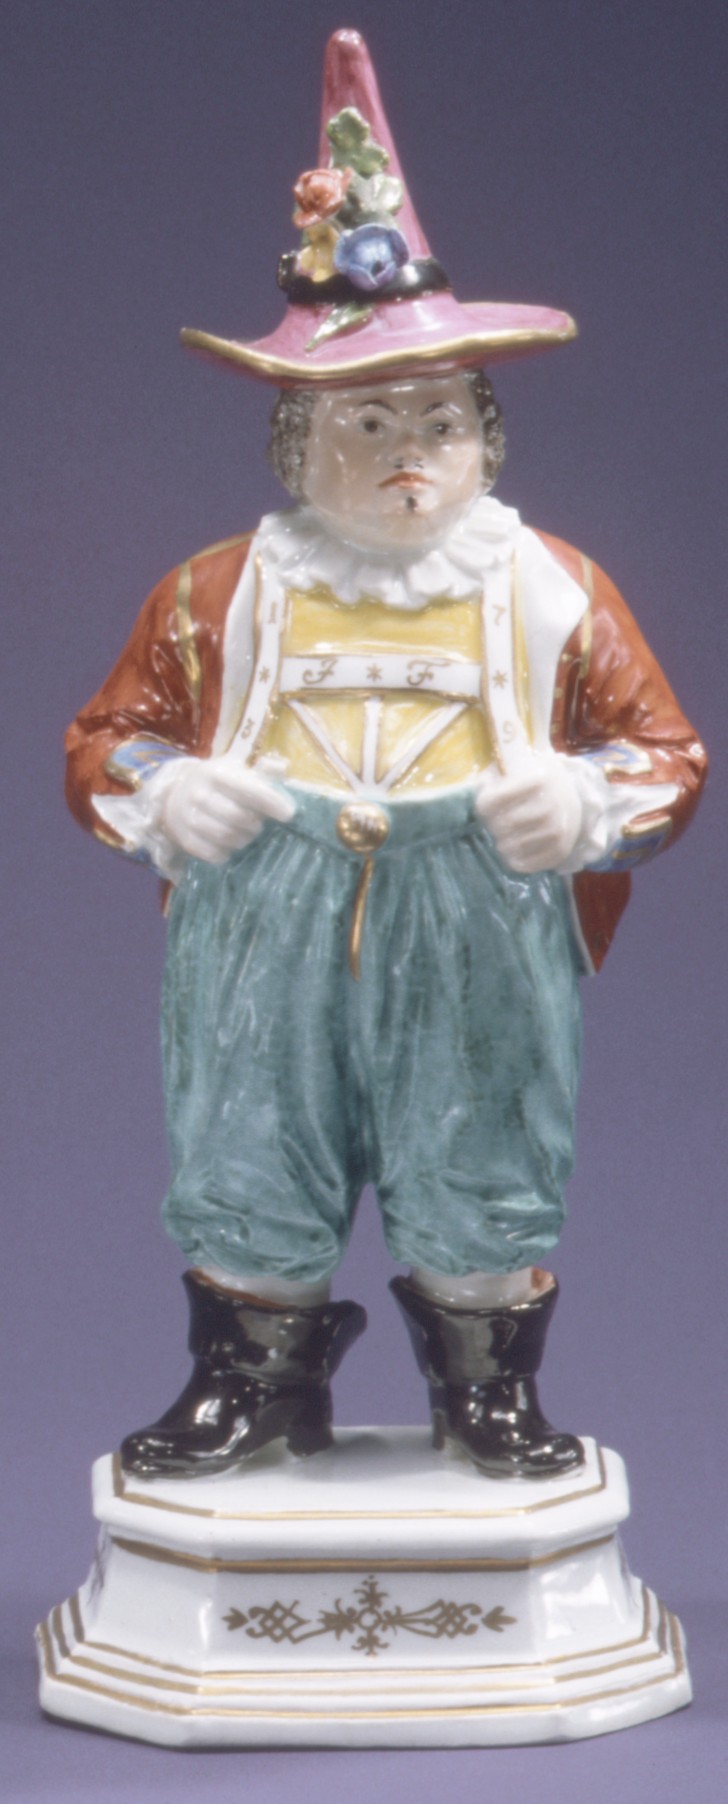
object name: figure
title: The Court Jester Joseph Fröhlich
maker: johann joachim kändler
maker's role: modeler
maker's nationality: german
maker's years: 1706-1775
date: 1739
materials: hard paste porcelain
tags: men